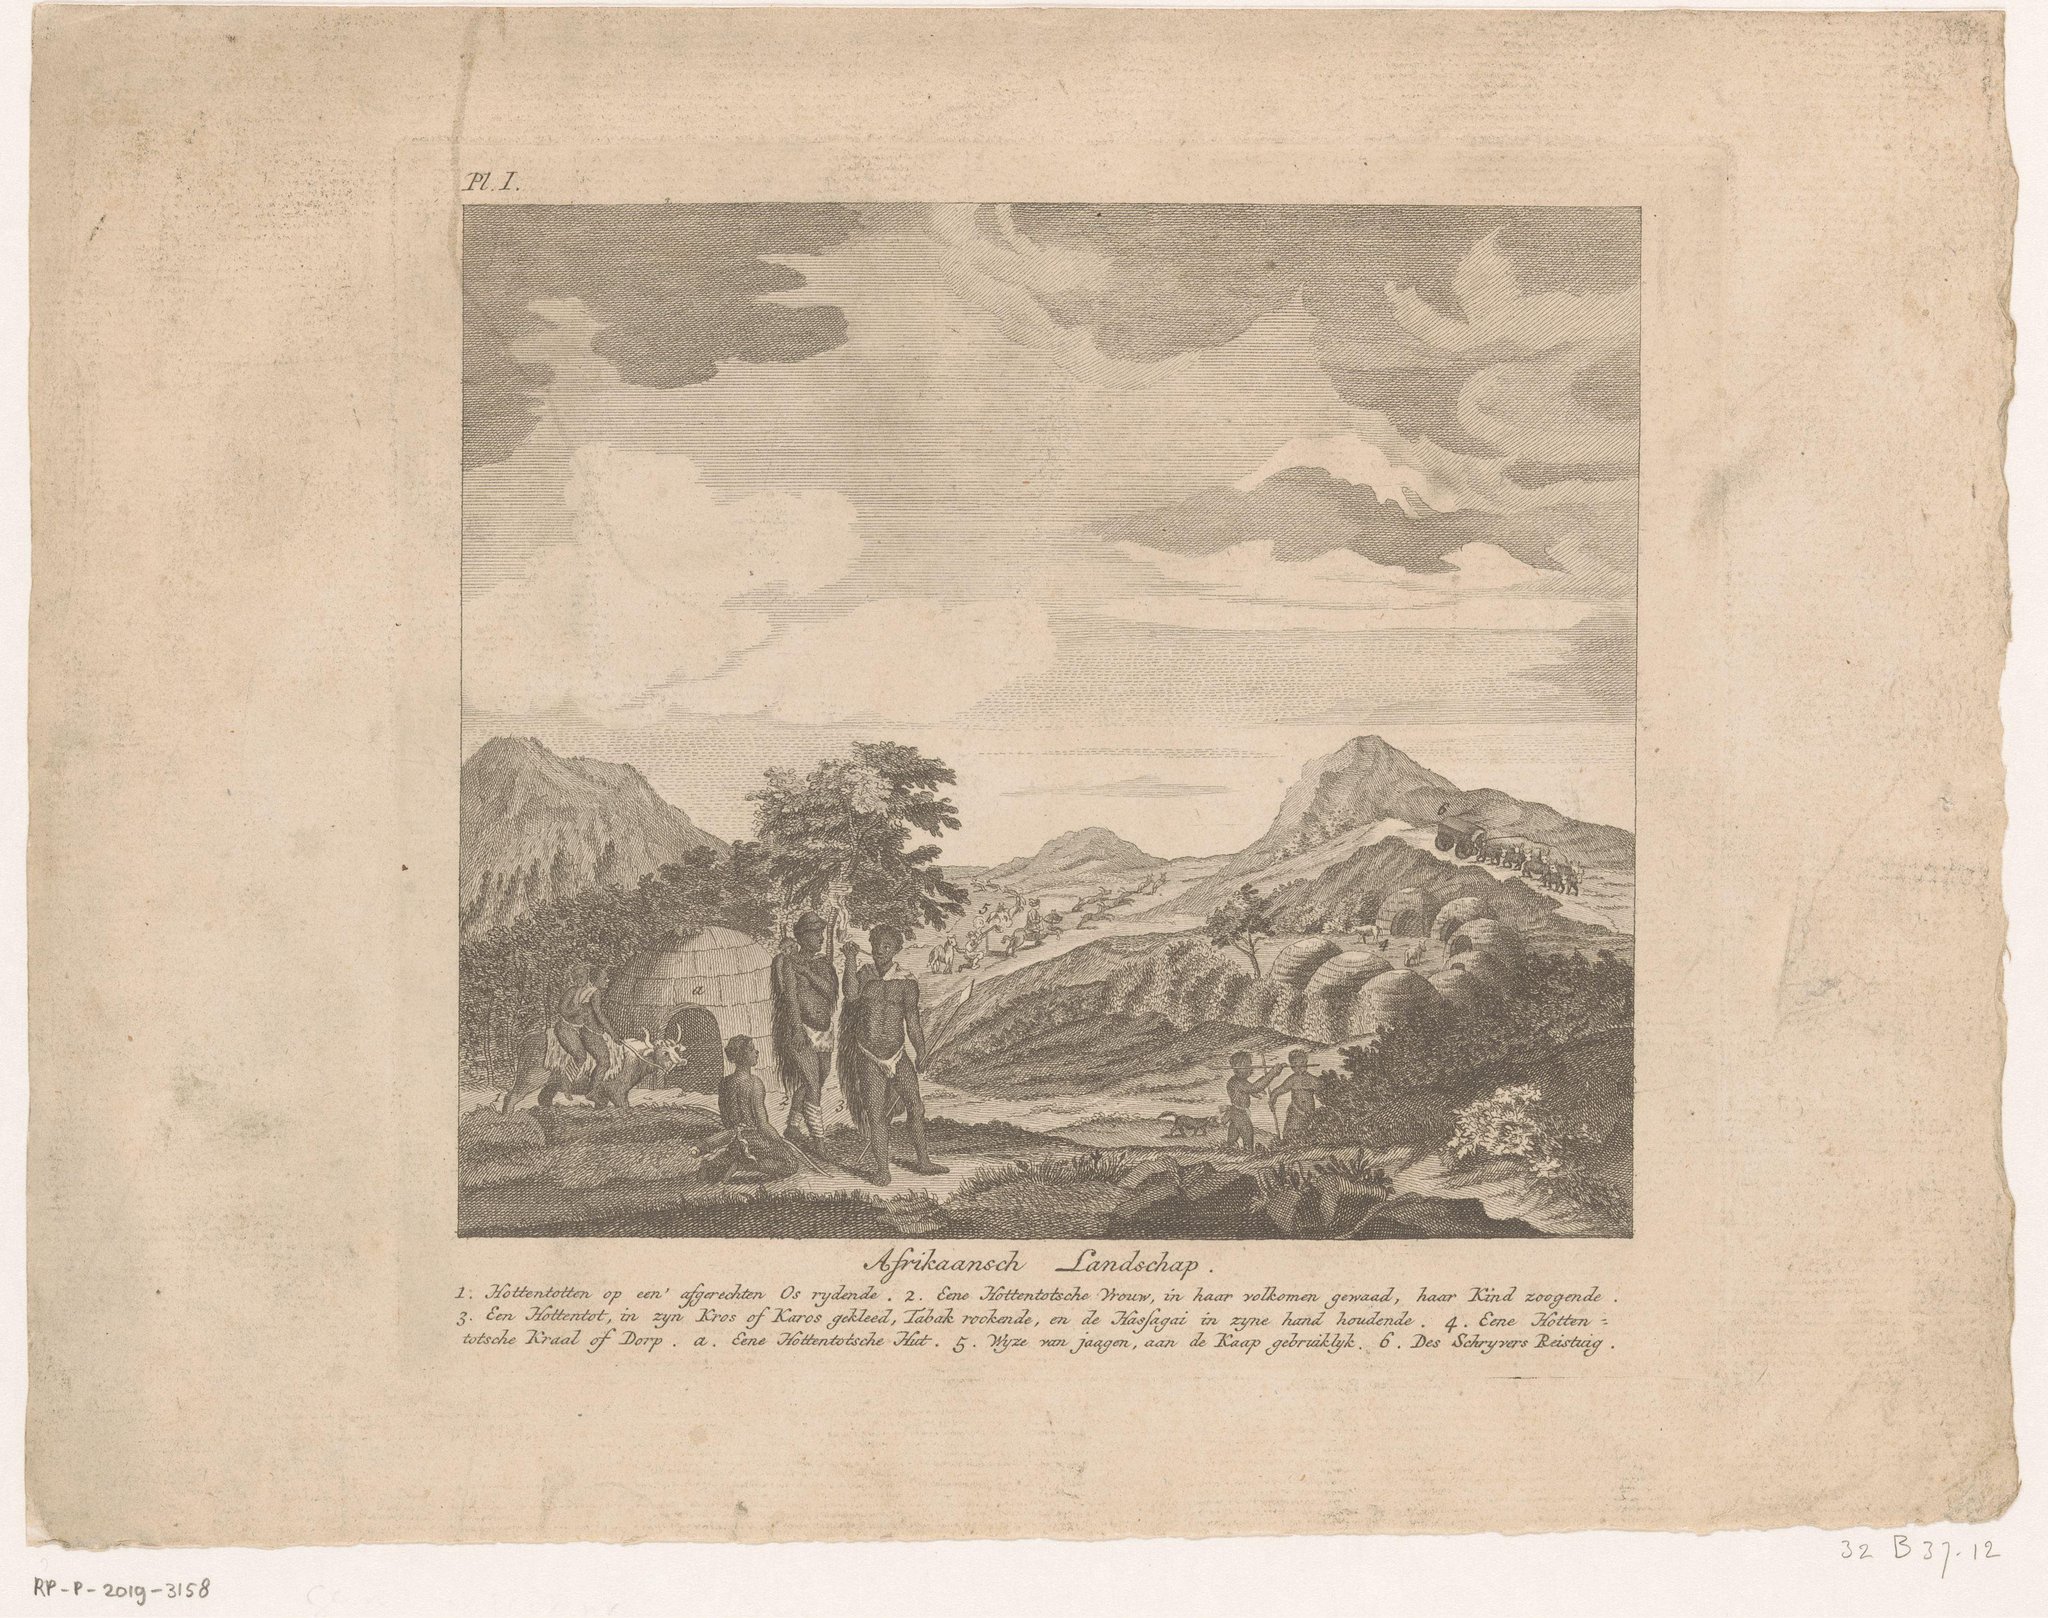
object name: print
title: Gezicht op een landschap in West-Kaap met Khoikhoi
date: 1787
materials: paper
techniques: etching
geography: amsterdam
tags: khoikhoi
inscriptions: collector's mark: Lugt 2228, watermark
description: Genummerd linksboven: Pl. I. In de prent cijfers en letters die verdere uitleg bieden.